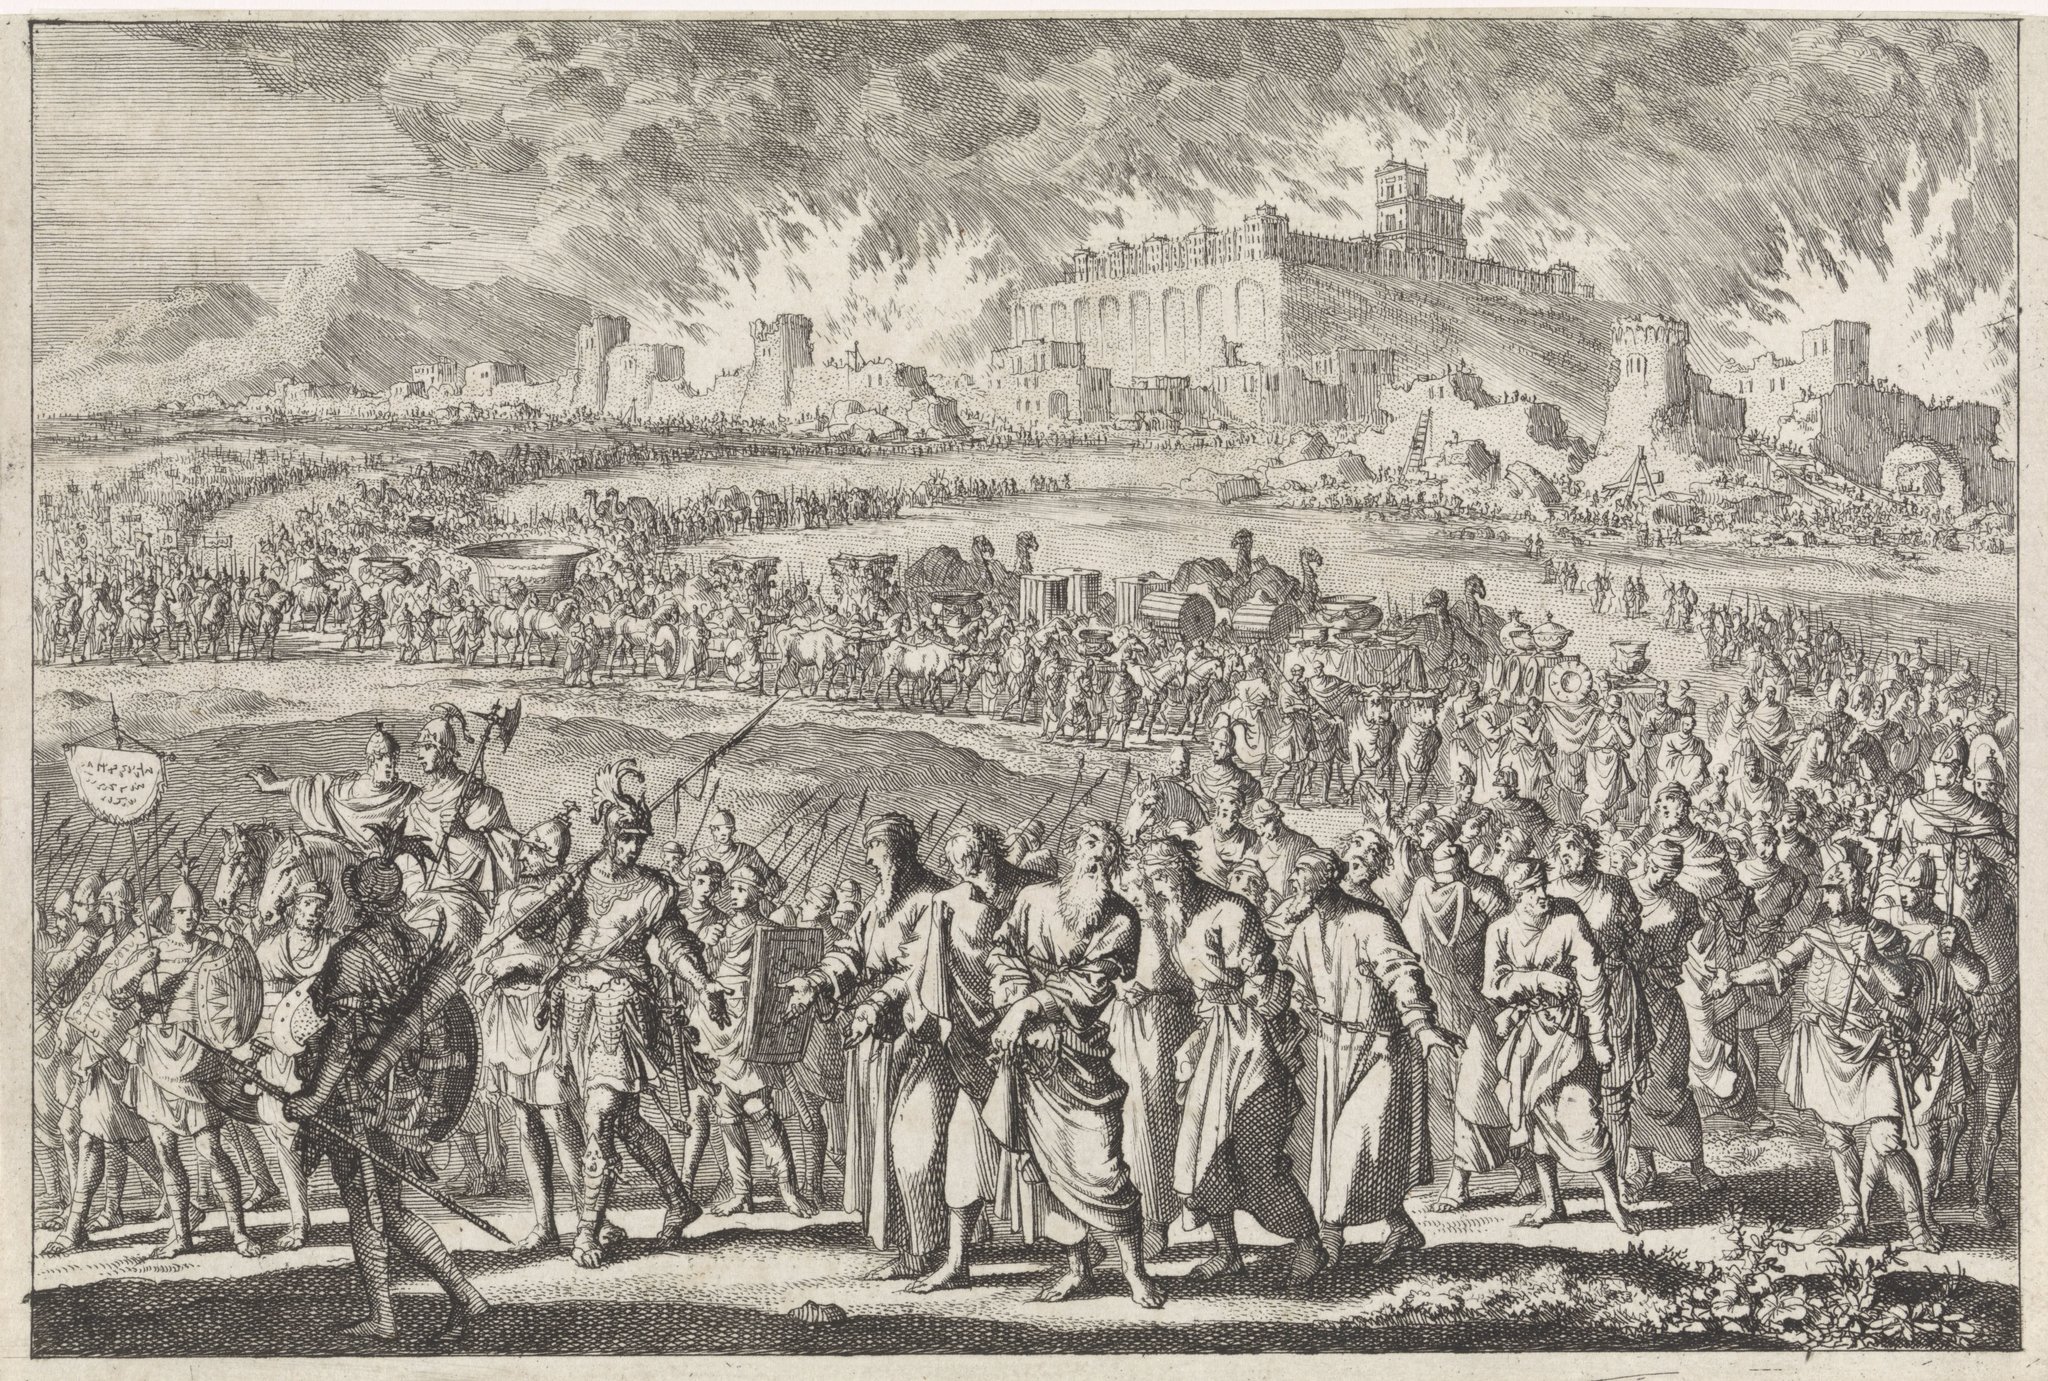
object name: print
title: Vernietiging van Jeruzalem door het Babylonische leger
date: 1700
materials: paper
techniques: etching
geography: amsterdam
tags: the people of judah, except the poorest, are taken to babylonia ~ story of zedekiah, nebuzaradan, commander of the babylonian army, burns down the temple and the palace of jerusalem ~ second siege of jerusalem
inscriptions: collector's mark: Lugt 2228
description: Na het beleg van Jeruzalem vertrekt het Babylonische leger terug naar huis met de geplunderde schatten van de stad. De bevolking van Jeruzalem wordt in slavernij meegenomen. Op de achtergrond Jeruzalem in de vlammen.